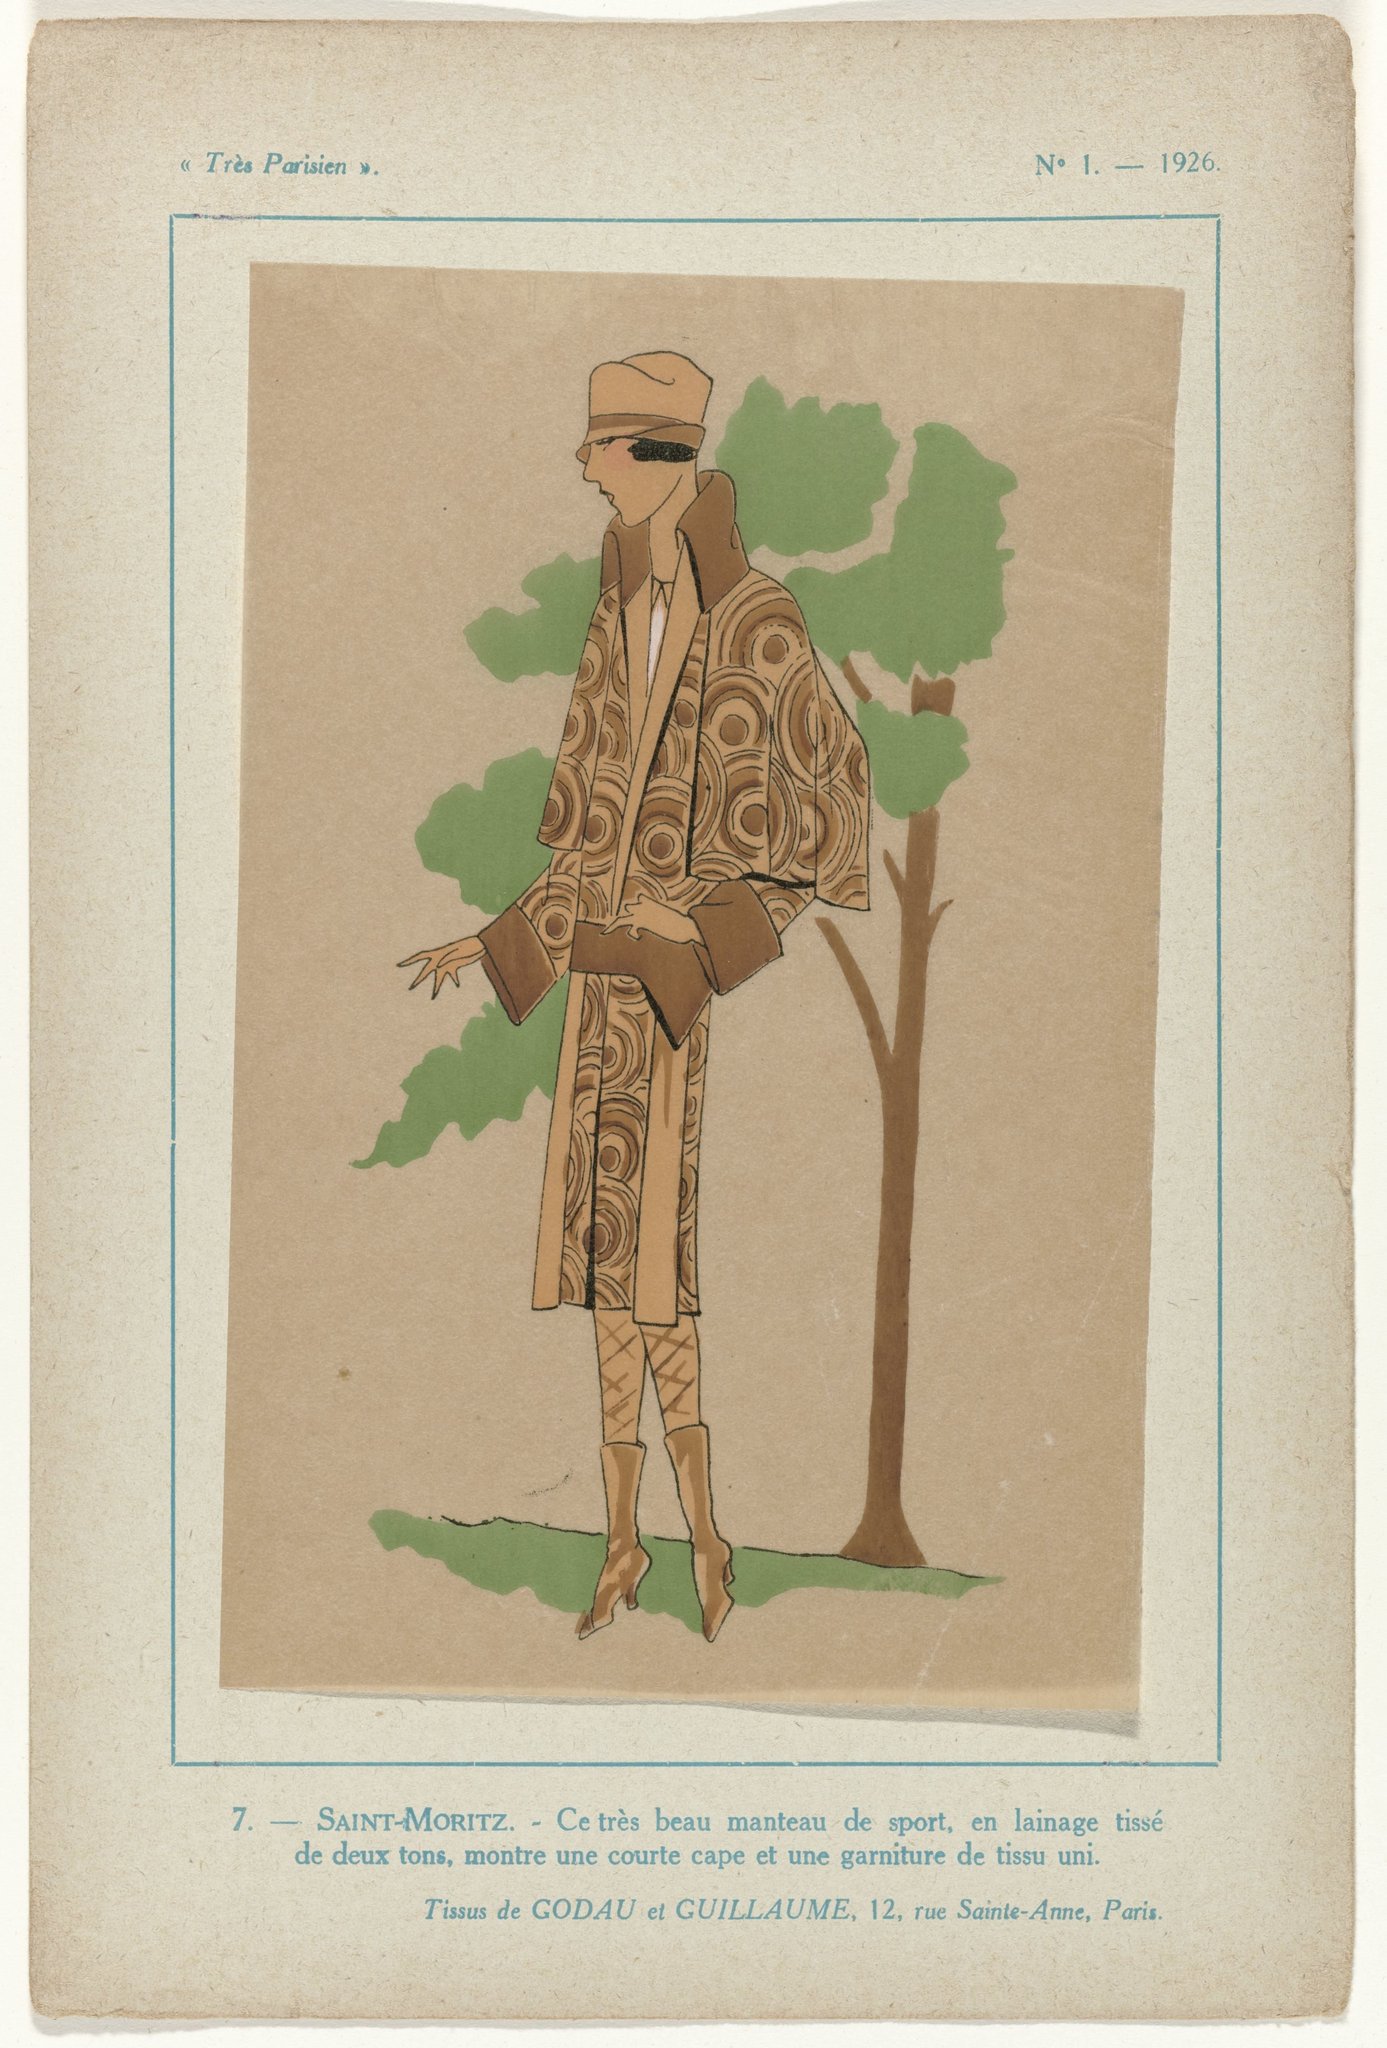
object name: fashion print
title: Très Parisien, 1926, No. 1, Pl. 7: - SAINT-MORITZ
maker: g-p. joumard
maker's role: publisher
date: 1926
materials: paper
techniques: hand coloring, letterpress printing, lithography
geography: paris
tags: boots (+ women's clothes), fashion plates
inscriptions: caption, SAINT MORIT: ‘Ce très beau manteau de sport, en lainage tissé de deux tons, montre une courte cape et une garniture de tissu uni.’, caption: ‘Tissus de GODEAU et GUILLAUME, 12, rue Sainte-Anne, Paris’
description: Sportmantel van wol, in beige-bruin, met korte schoudercape. Prent uit het modetijdschrift Très Parisien...La Mode, Le Chic, L'Élégance (1920-1936)